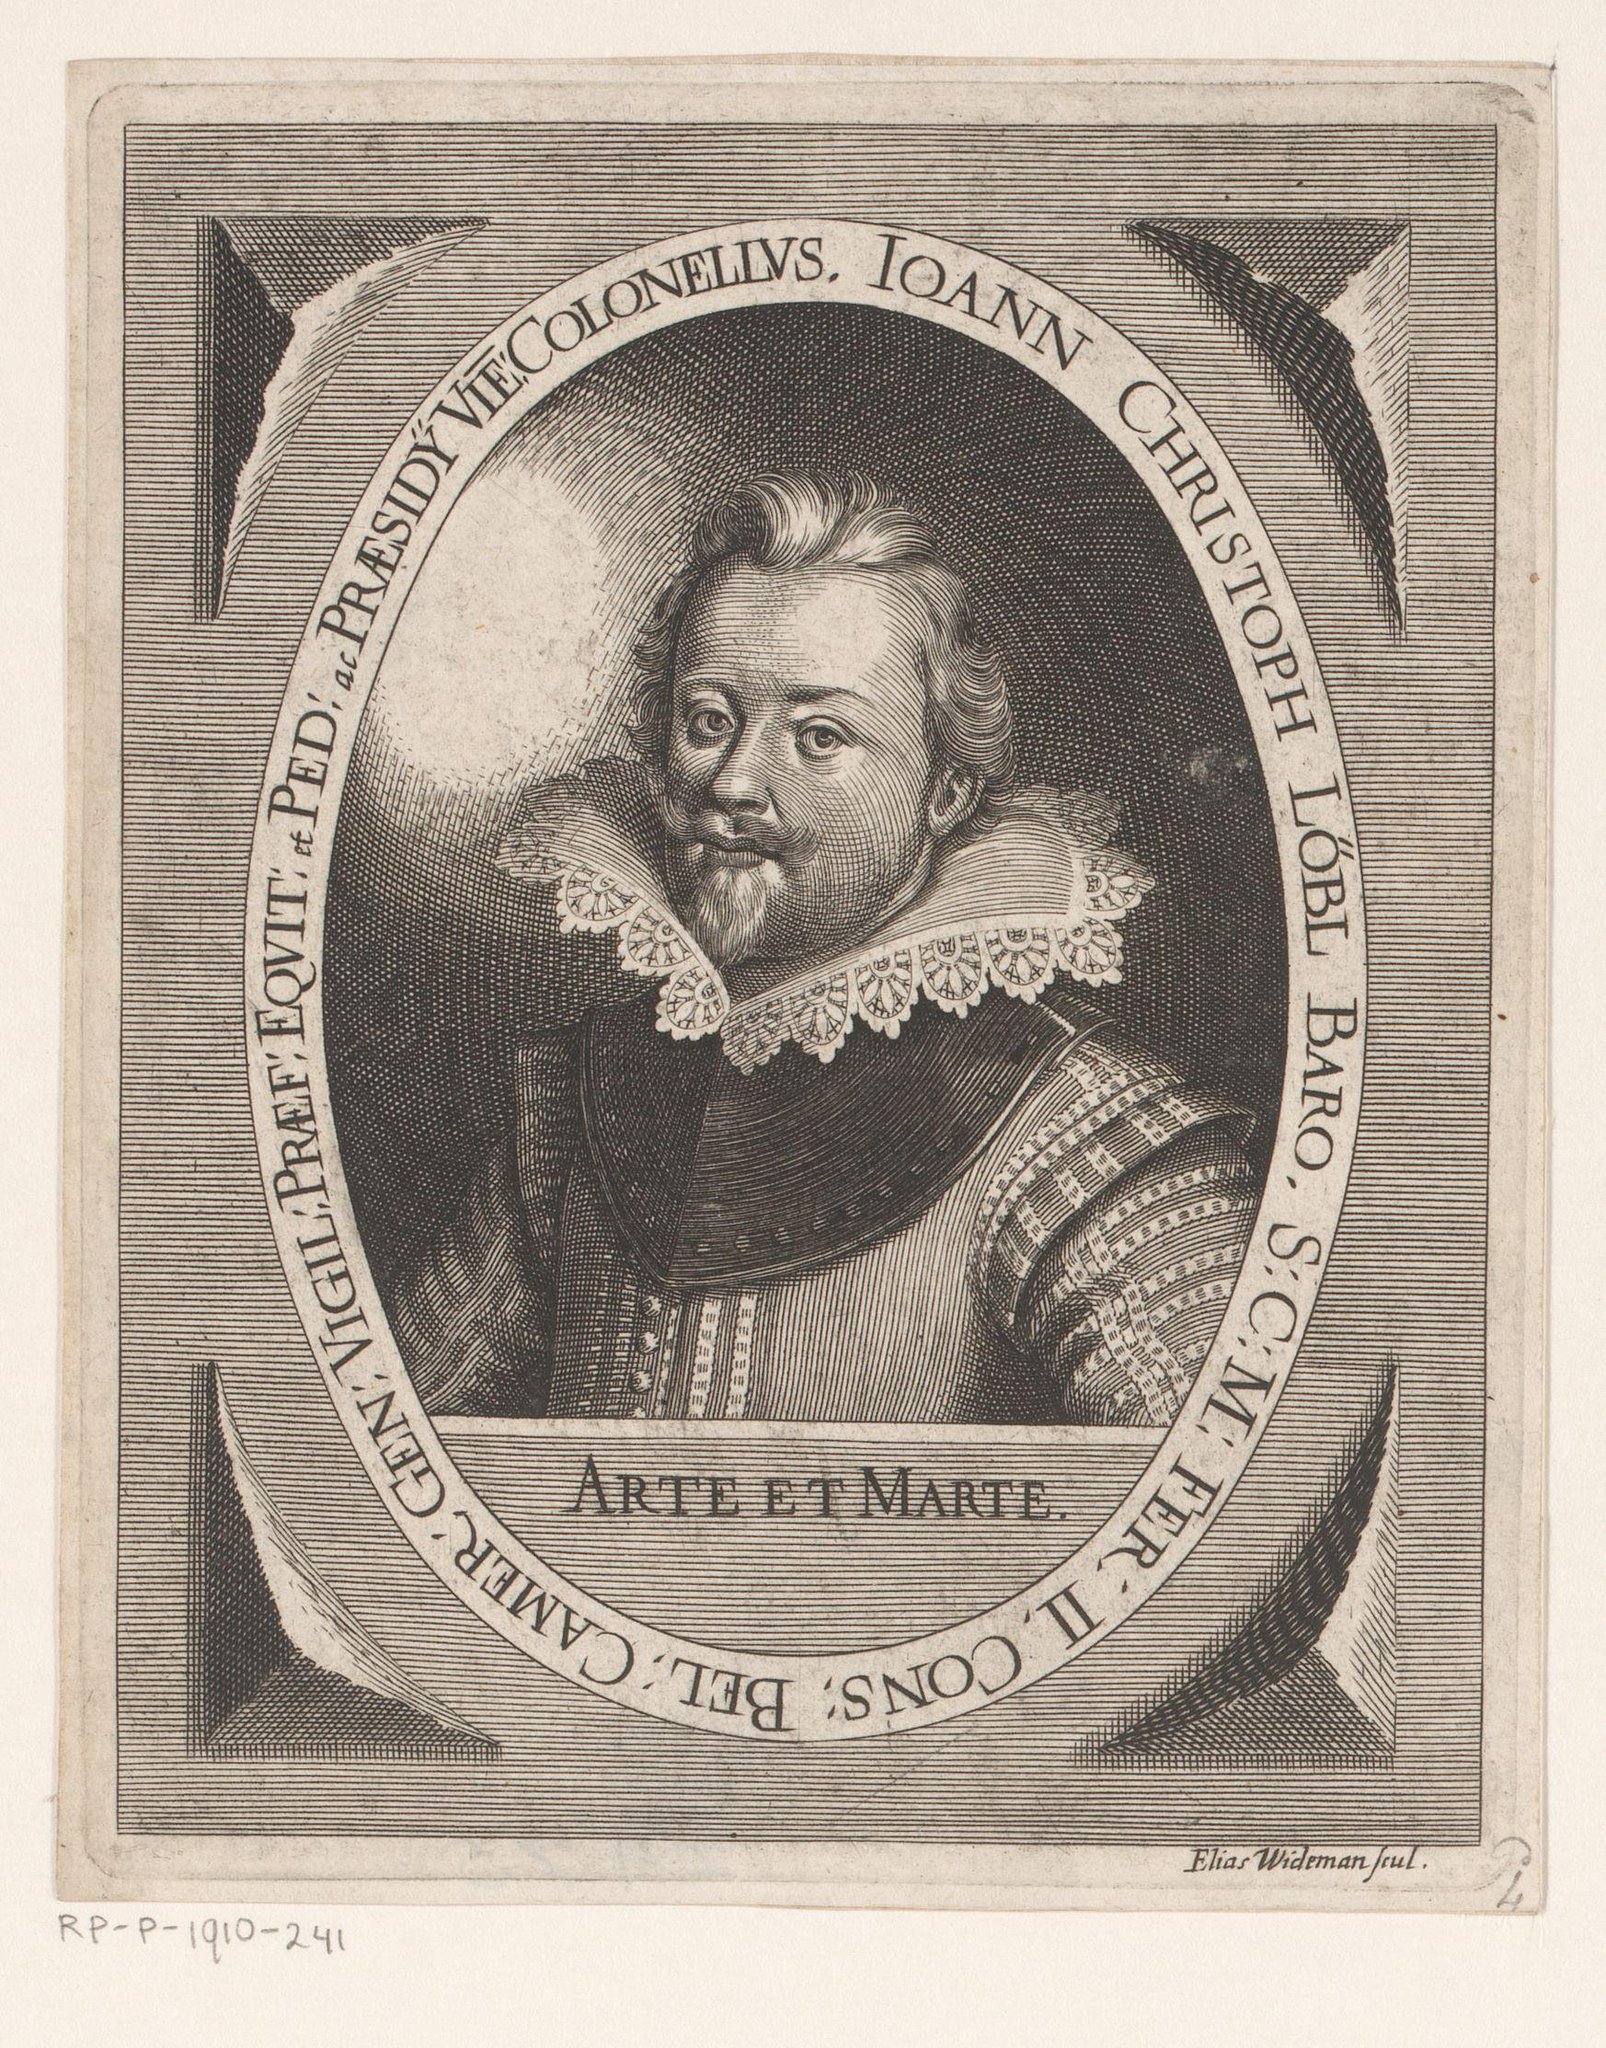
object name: print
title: Portret van Johann Christoph Löbl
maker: elias widemann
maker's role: print maker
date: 1634-1651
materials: paper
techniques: engraving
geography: vienna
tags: austria, historical persons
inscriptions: collector's mark: Lugt 2228